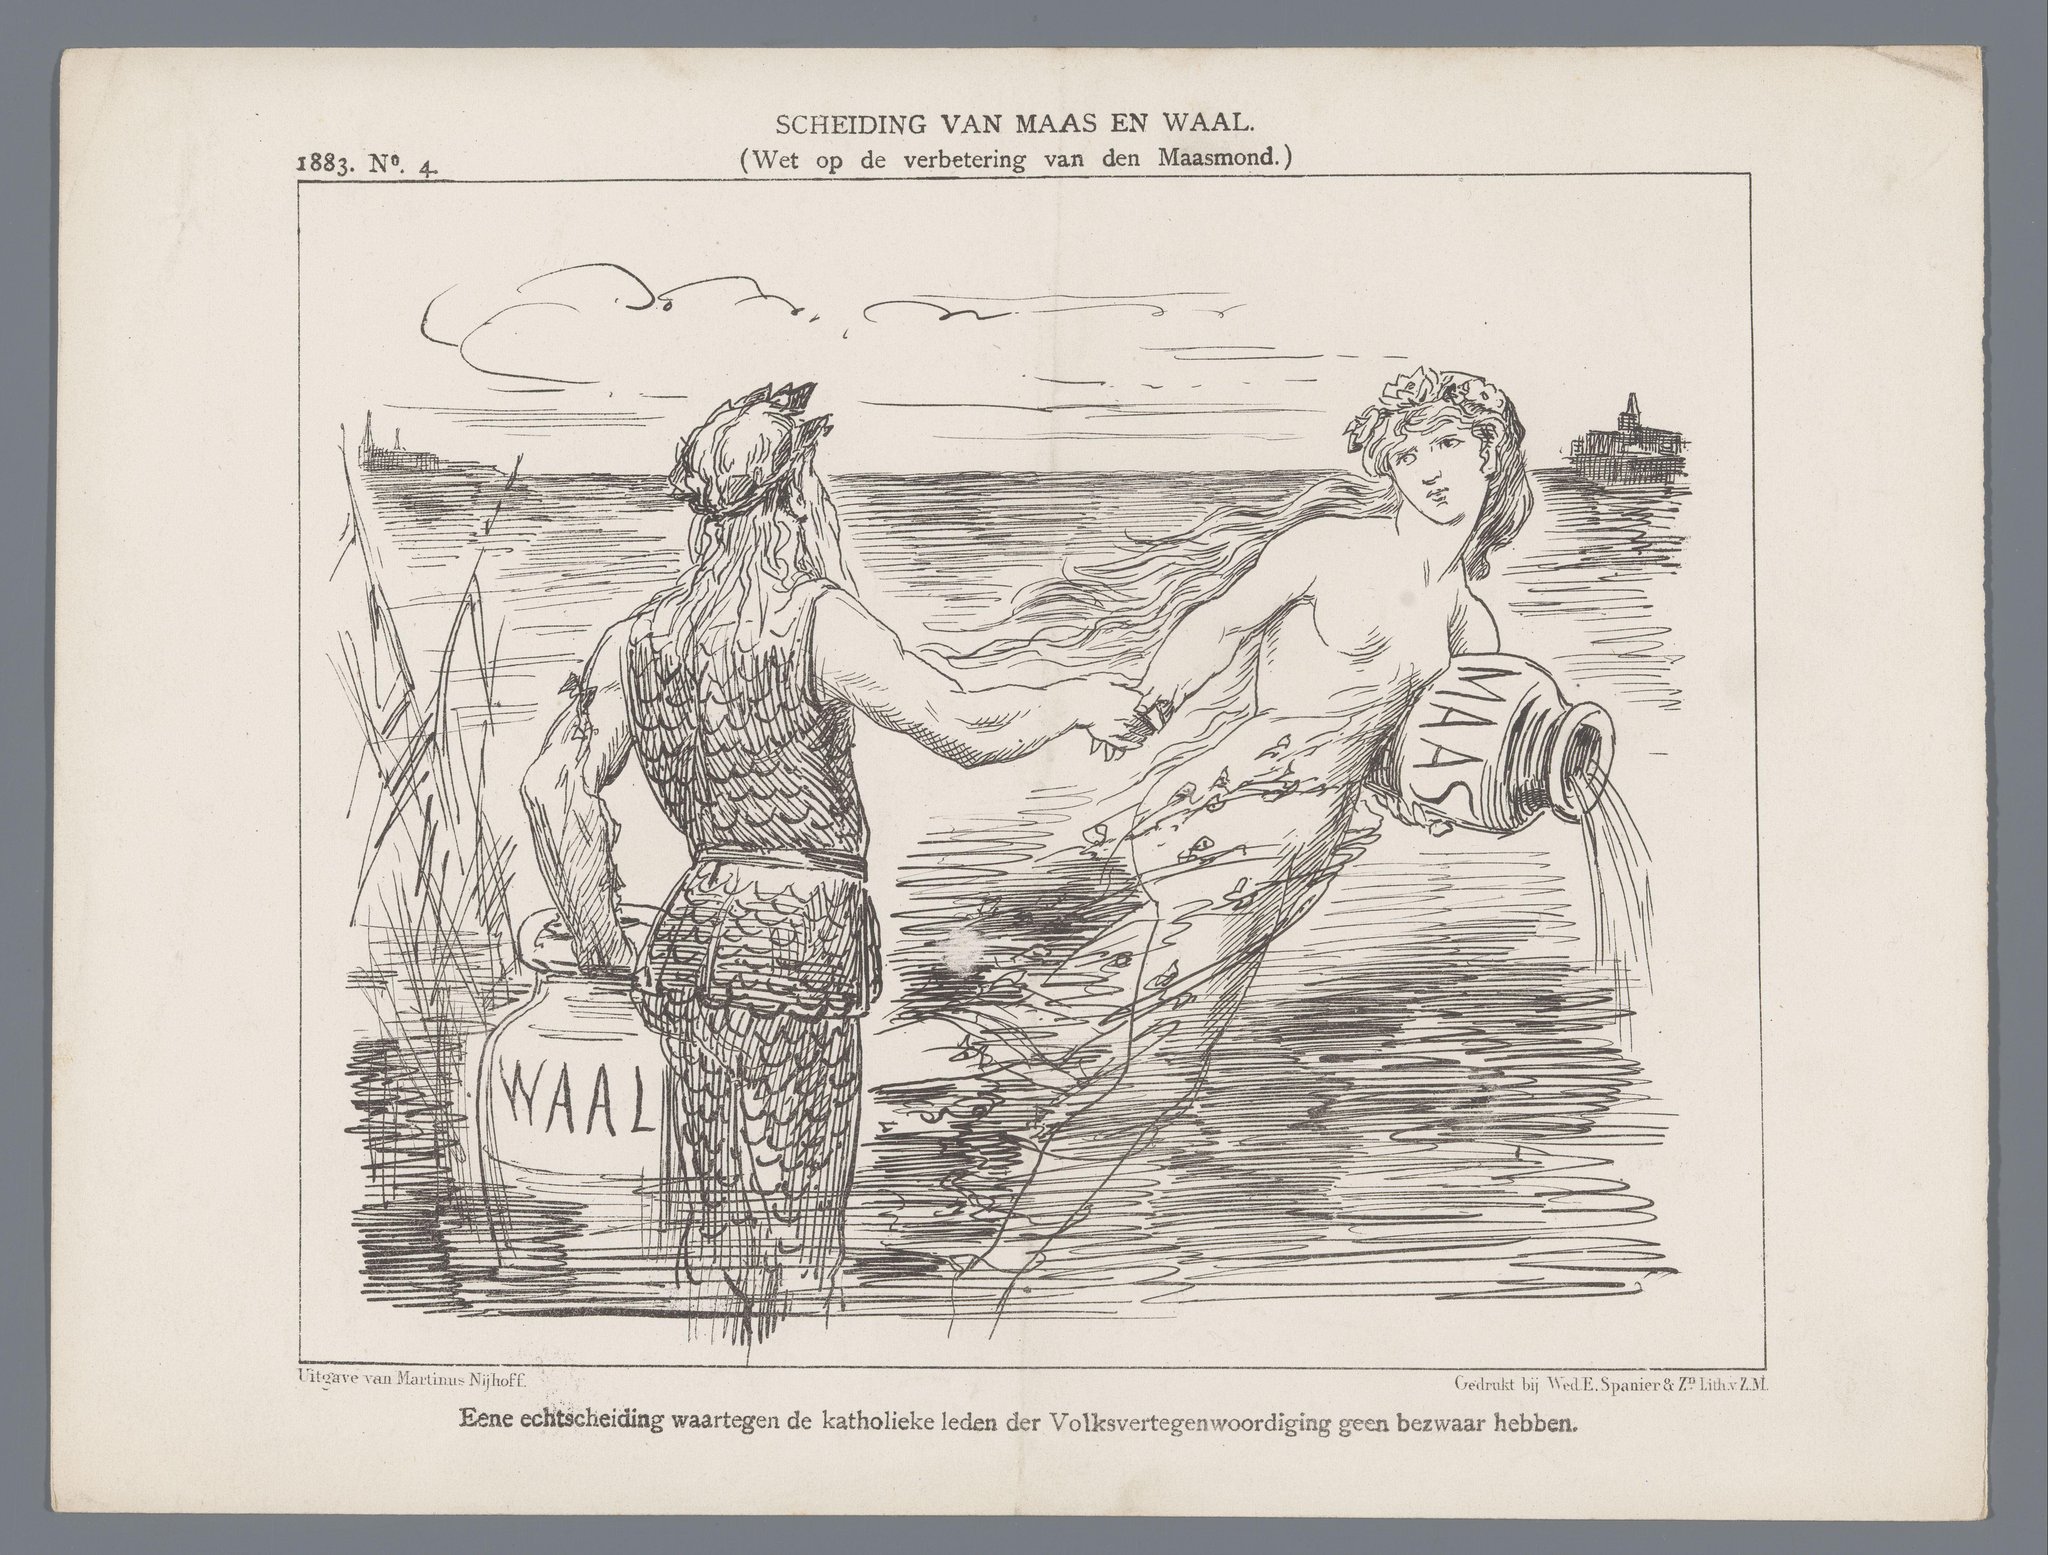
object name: print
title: Scheiding van Maas en Waal. (Wet op de verbetering van den Maasmond.)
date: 1883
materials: paper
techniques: lithograph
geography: netherlands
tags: maas, waal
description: Politieke spotprent over de wet op de verbetering van de Maasmond, 1883. Plaat verschenen bij het weekblad De Nederlandsche Spectator, nr. 4, 1883.